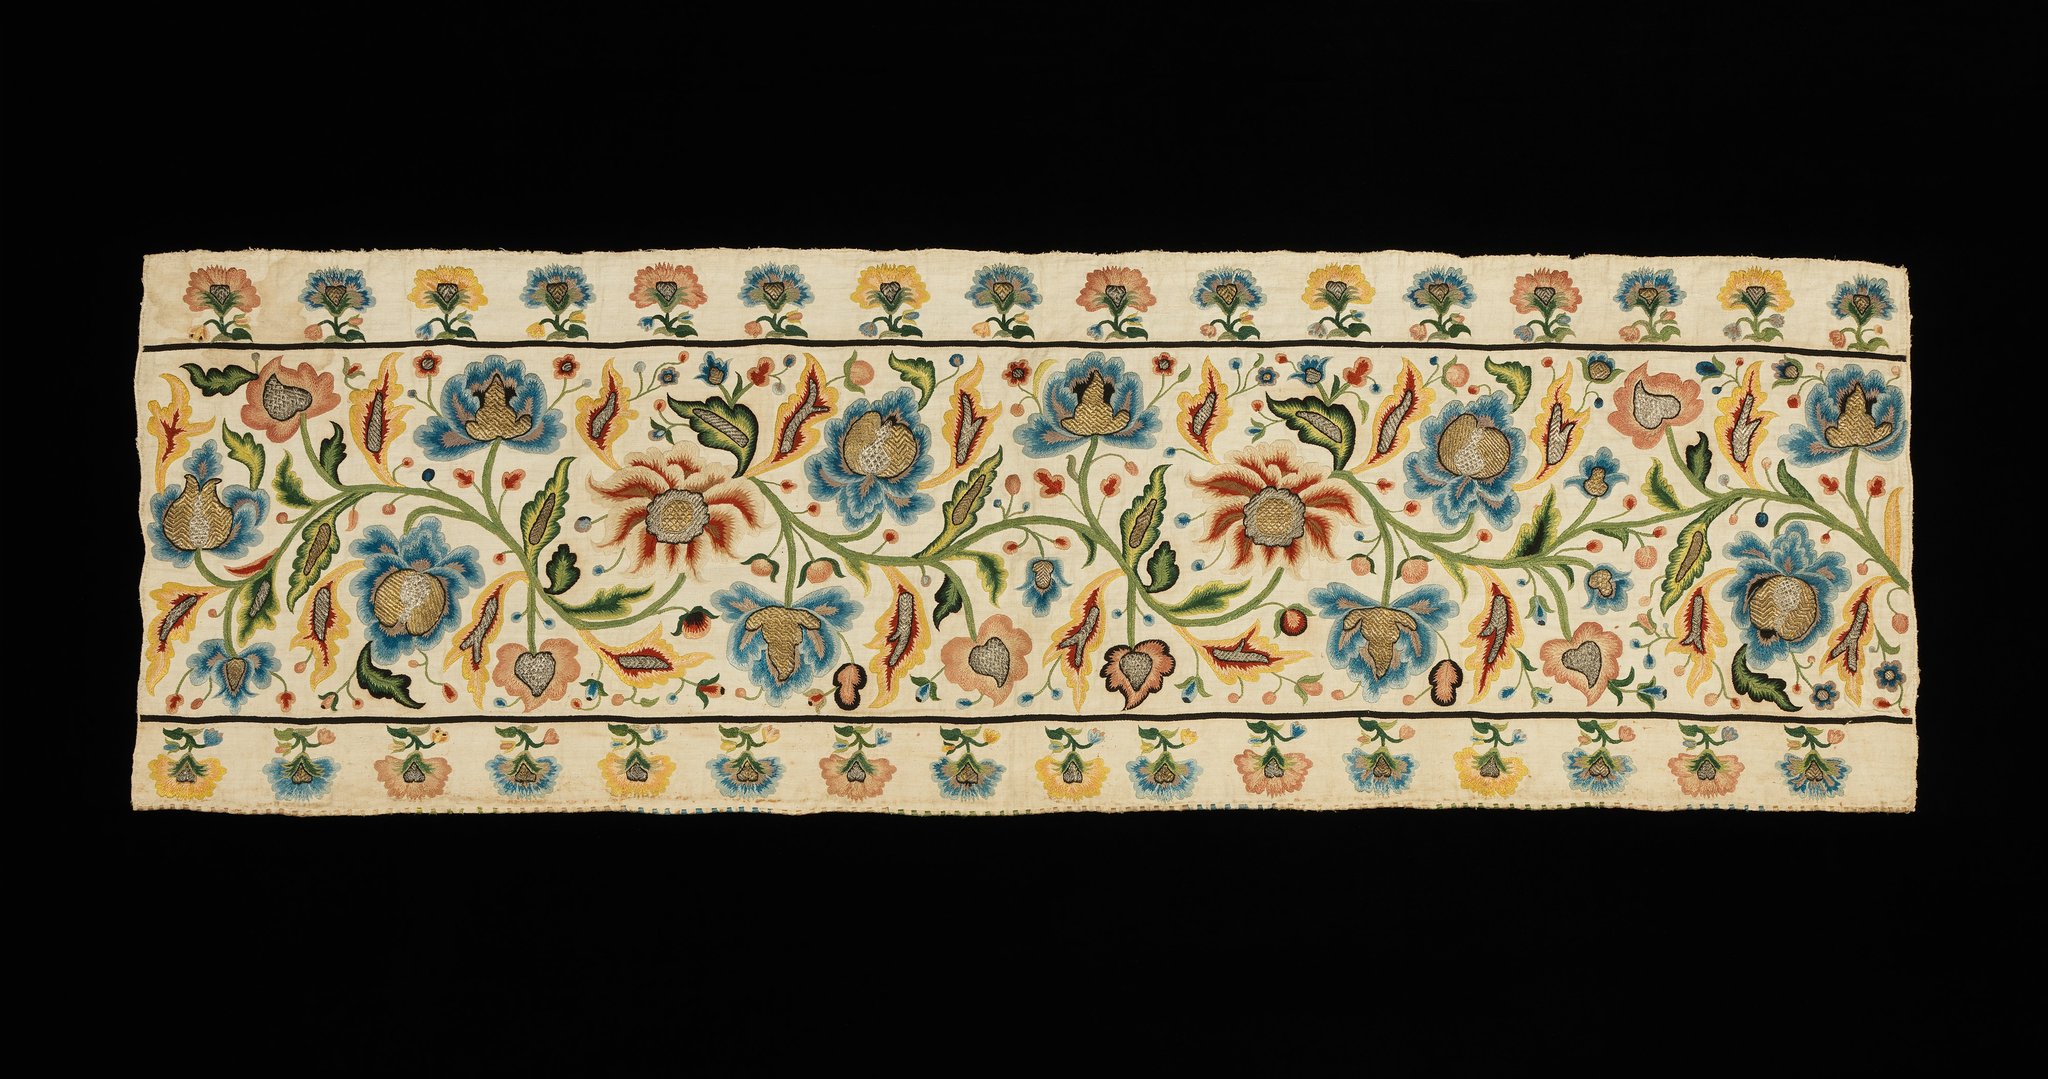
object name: textile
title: Fragment of a shirt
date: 1776-1800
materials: cotton, linen, silk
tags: flowers,leaves